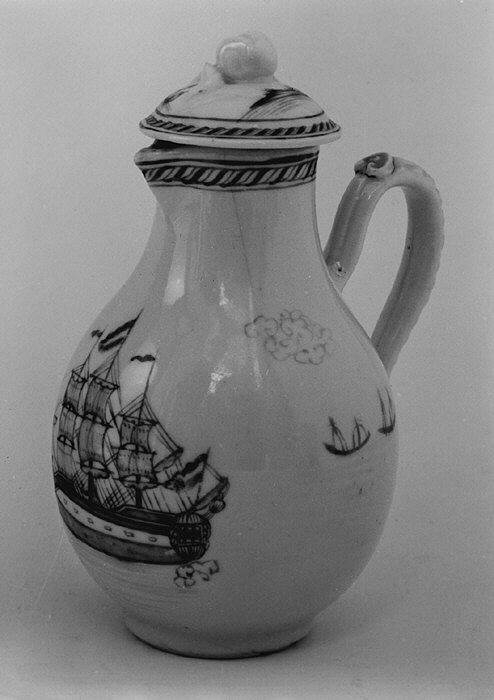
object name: milk jug with cover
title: Milk jug with cover (part of a set)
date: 1770-1780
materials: hard paste porcelain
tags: ships